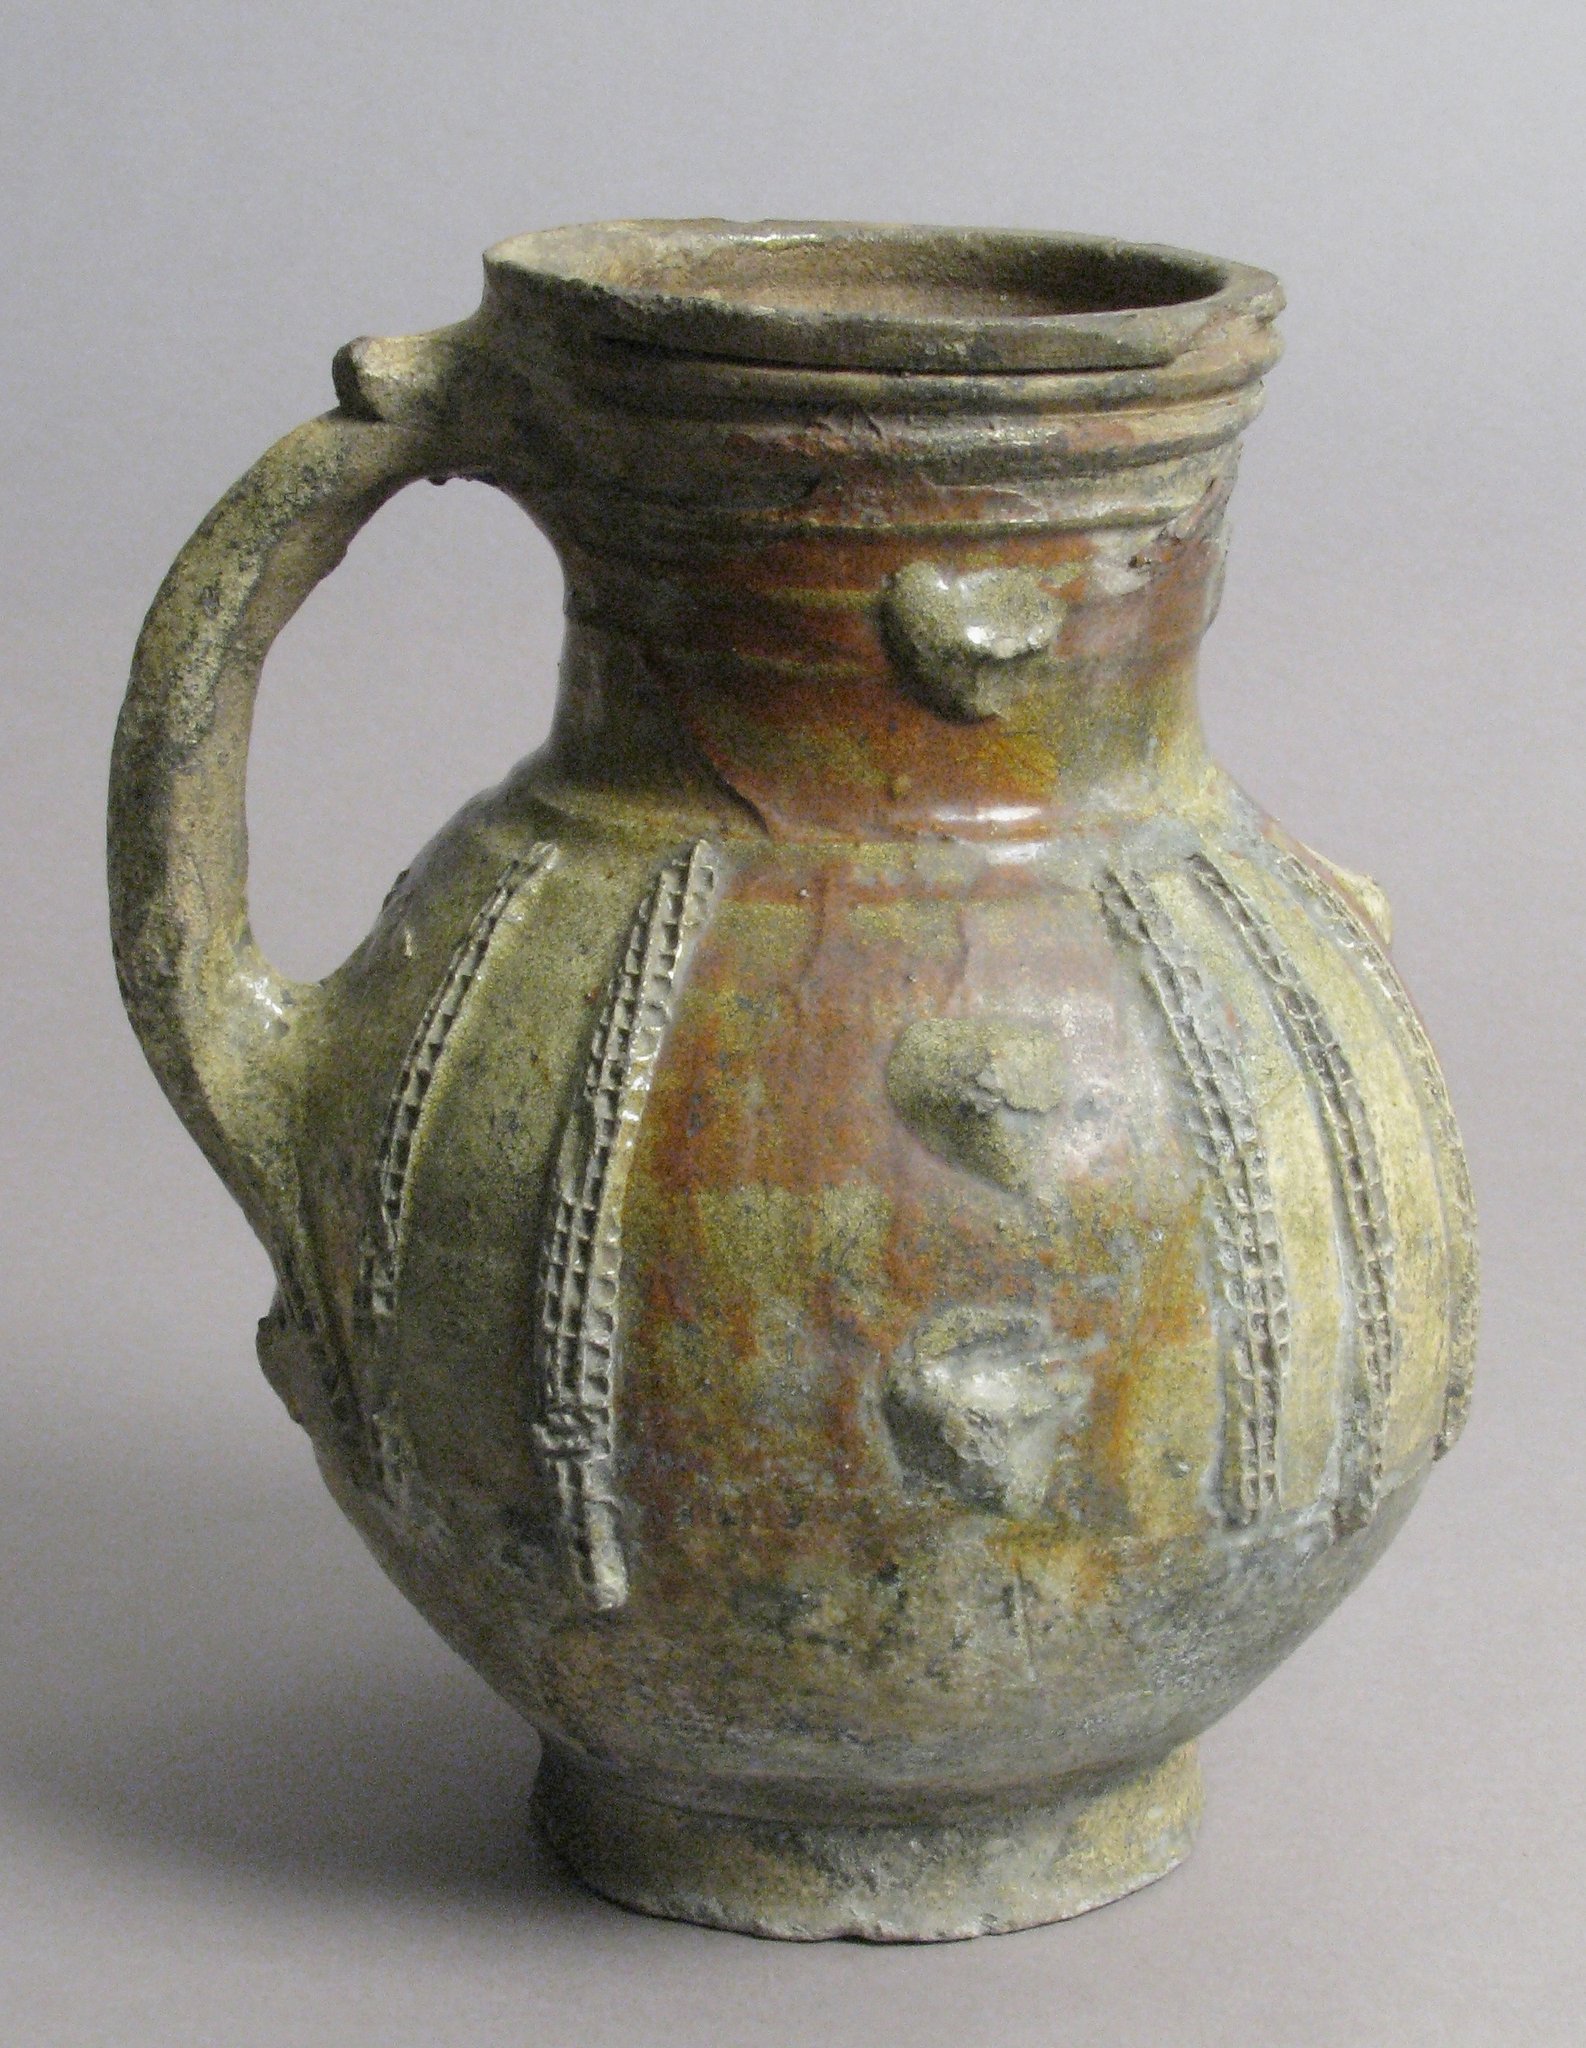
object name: jug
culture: french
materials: earthenware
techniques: glazing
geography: france